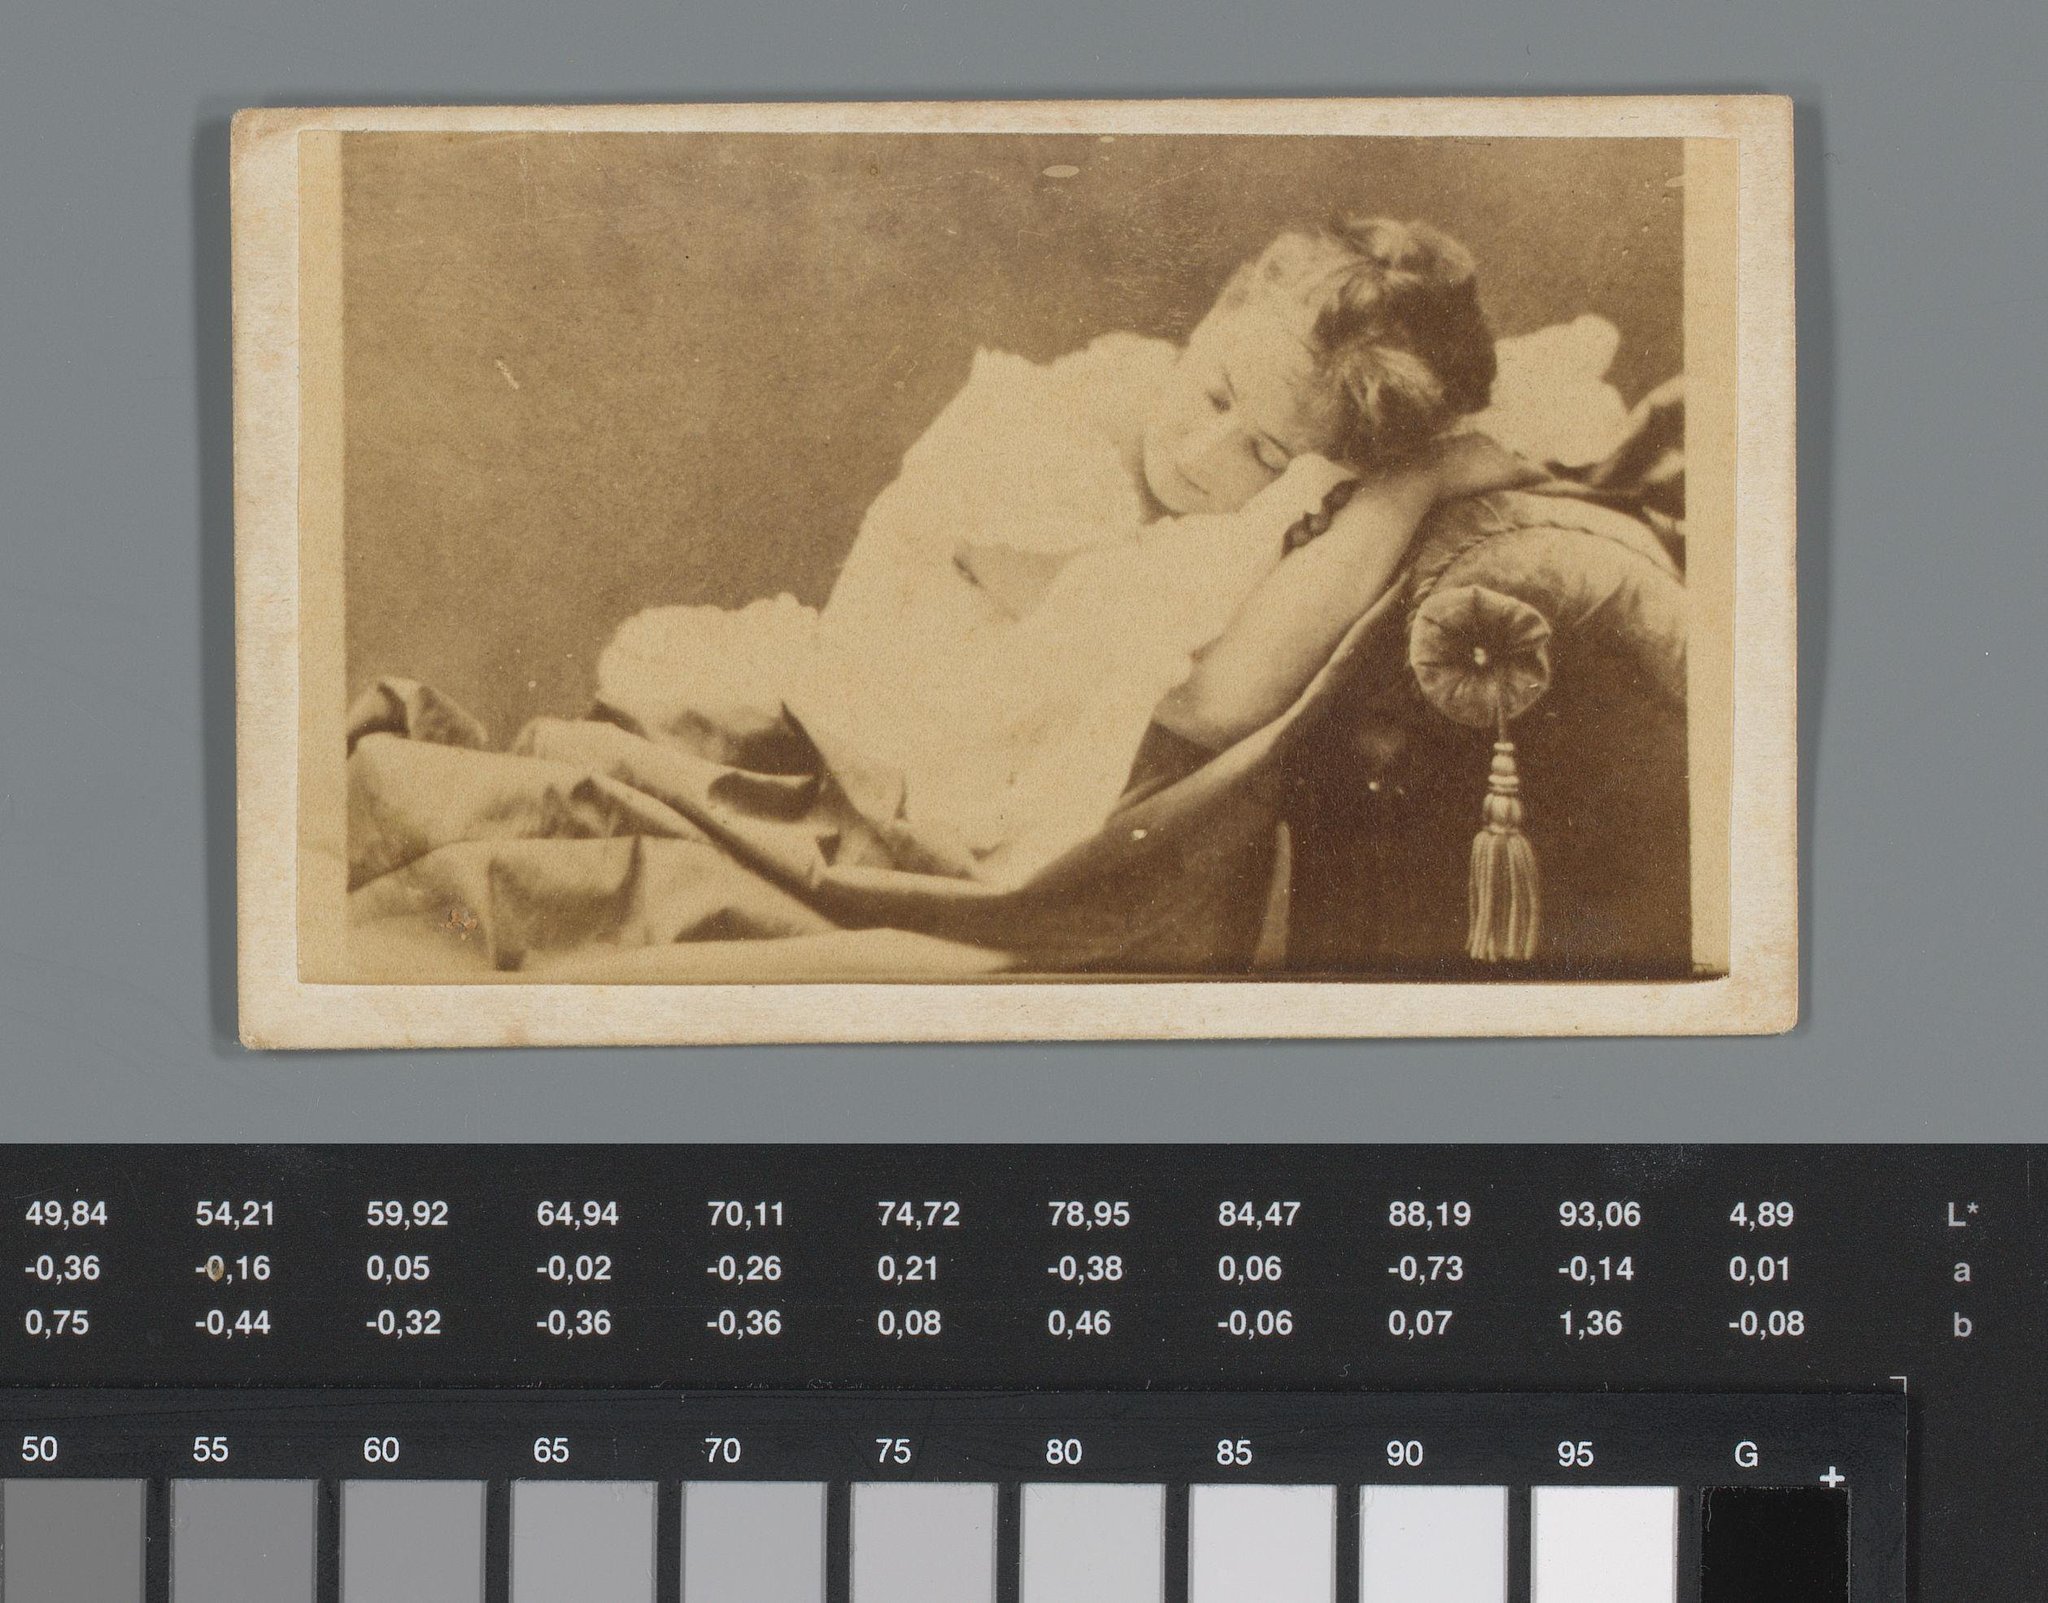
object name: carte de visite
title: Reclame voor kaartfoto's met een portret van een slapende Grace Rawlinson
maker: Anonymous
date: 1850-1915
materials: cardboard, photographic support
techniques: albumen print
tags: sleeping in chair, advertising, historical persons - bb - woman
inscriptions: inscription: ‘Photograph Novelty (...)/ PLEASE EXAMINE OUR GOODS’, inscription: ‘Nellie Marrey’